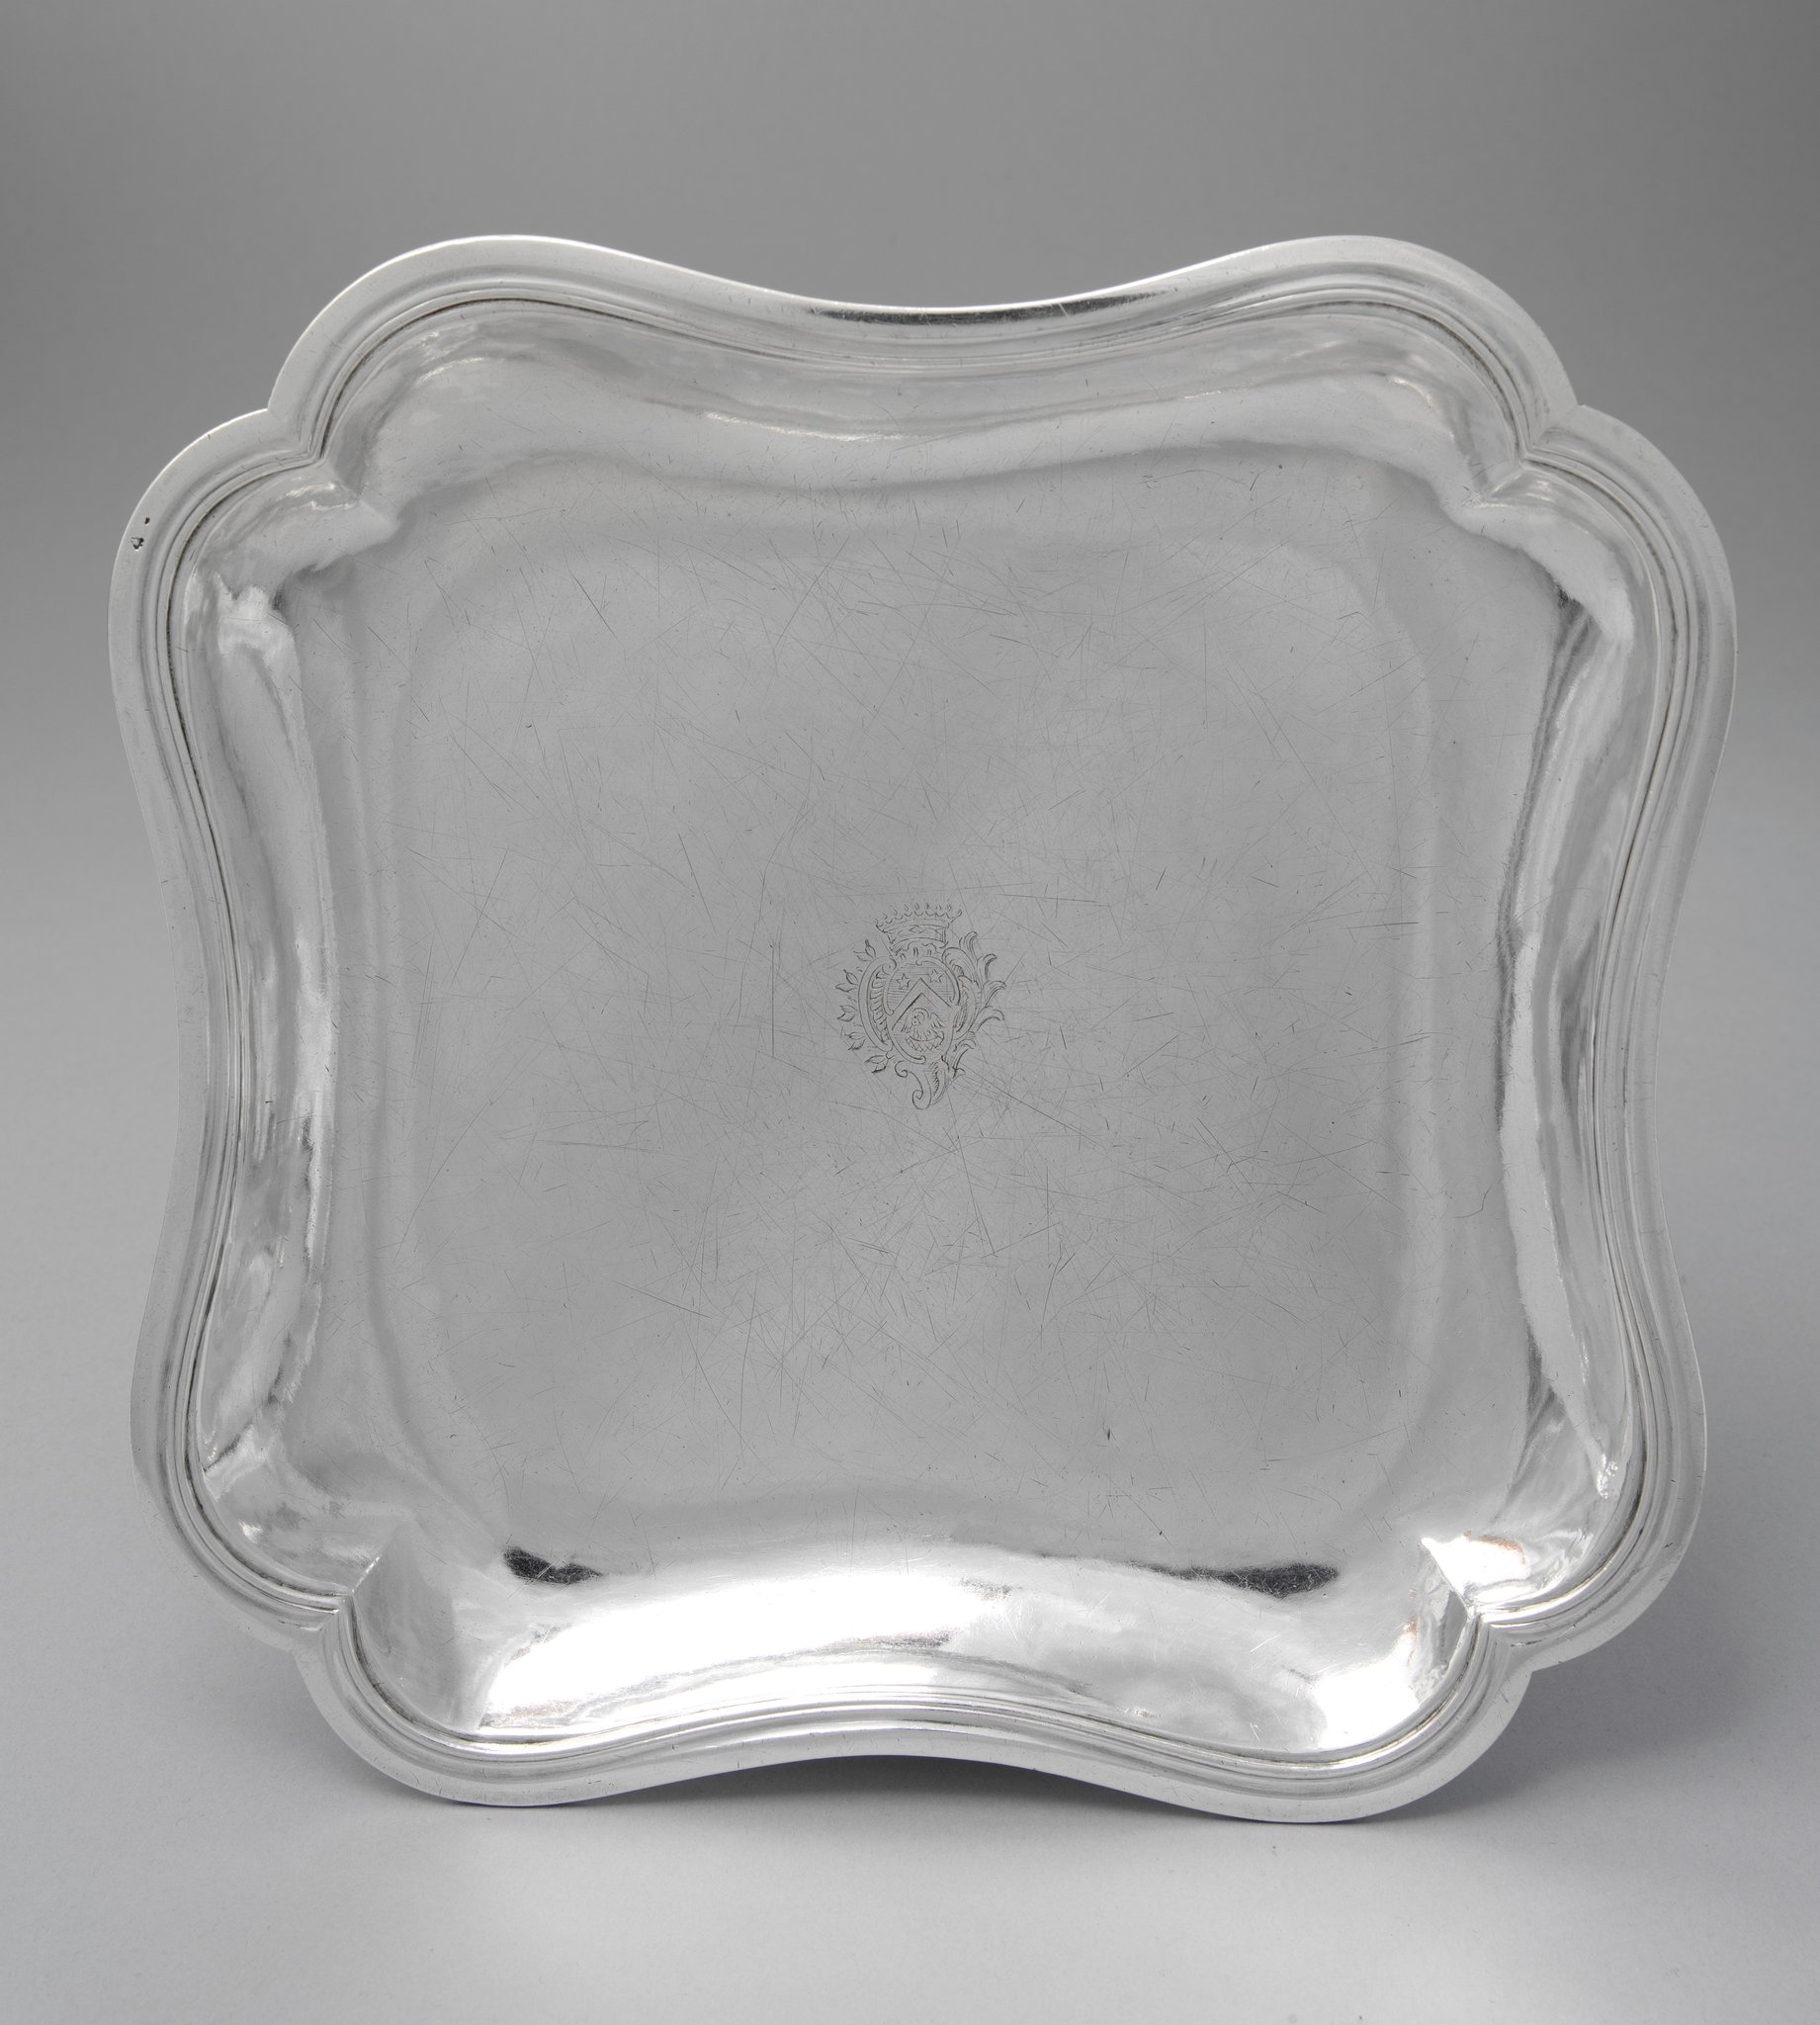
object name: dish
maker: gaspard burel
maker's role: maker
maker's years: 1747-1813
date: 1783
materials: silver